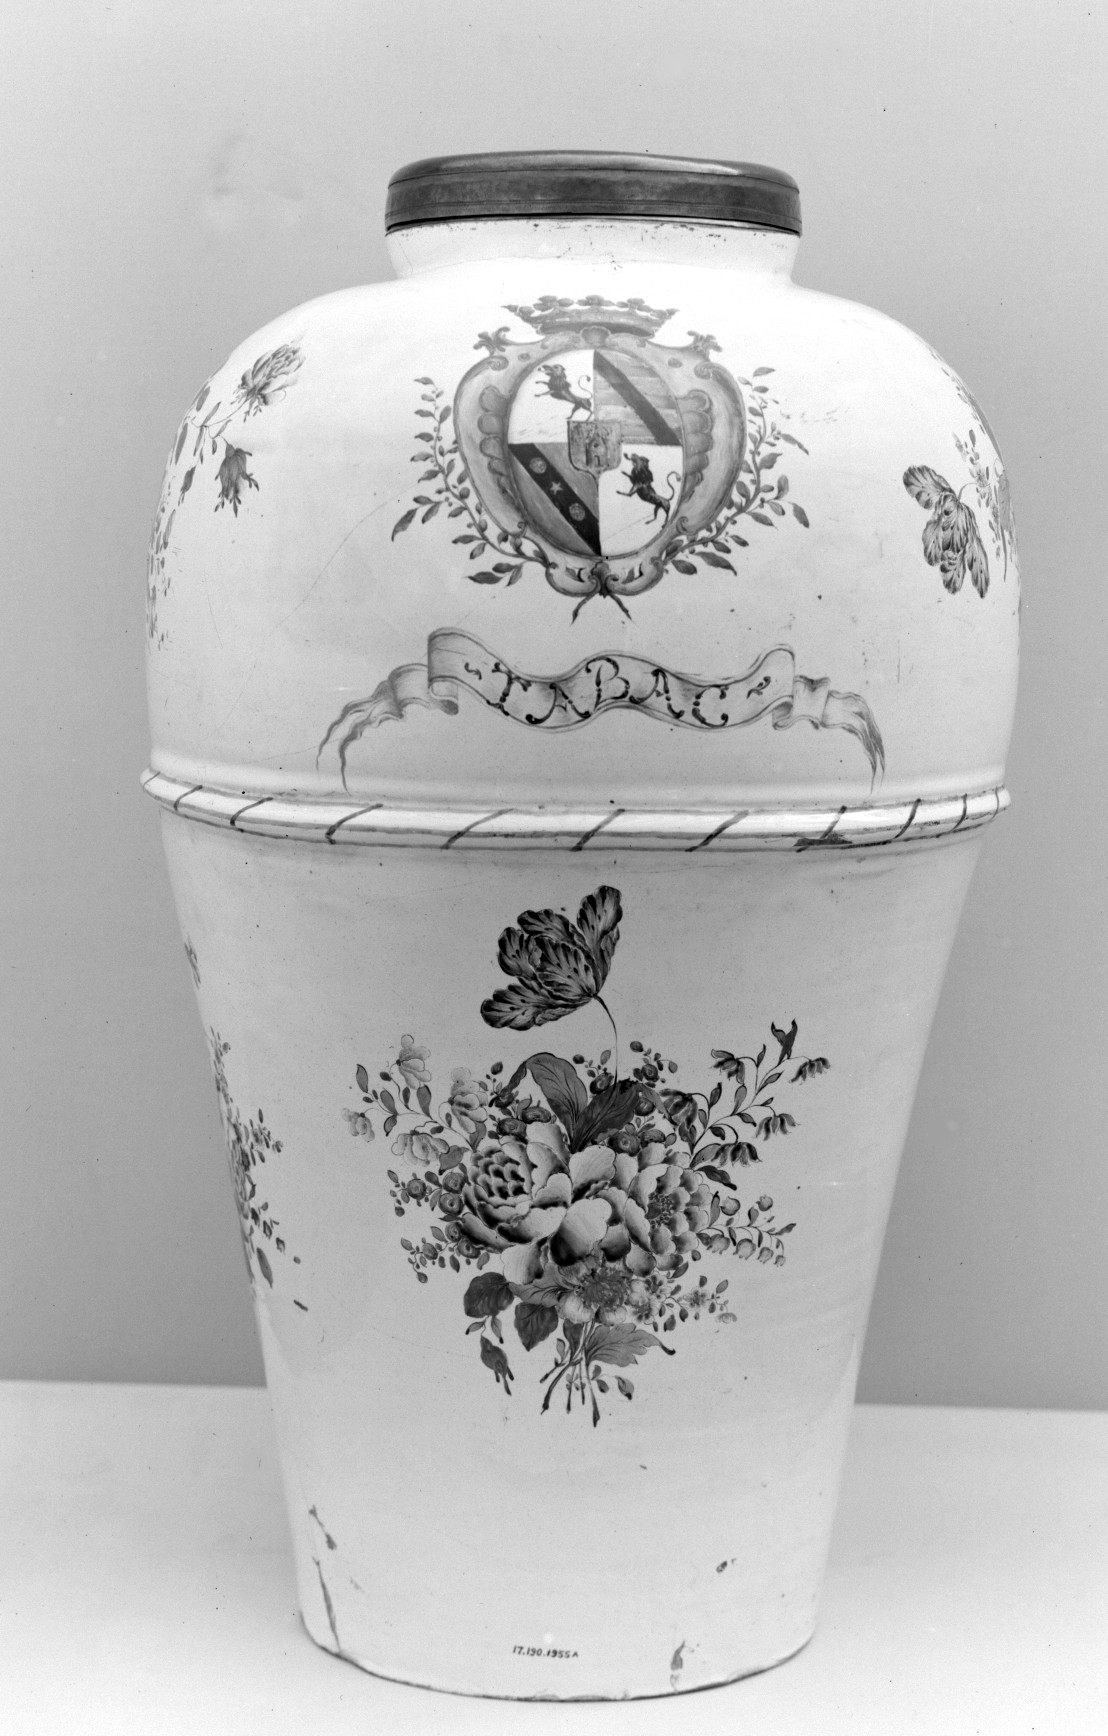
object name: tobacco jar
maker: sceaux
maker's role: manufactory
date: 1765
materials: faience, pewter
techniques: glazing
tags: flowers,coat of arms